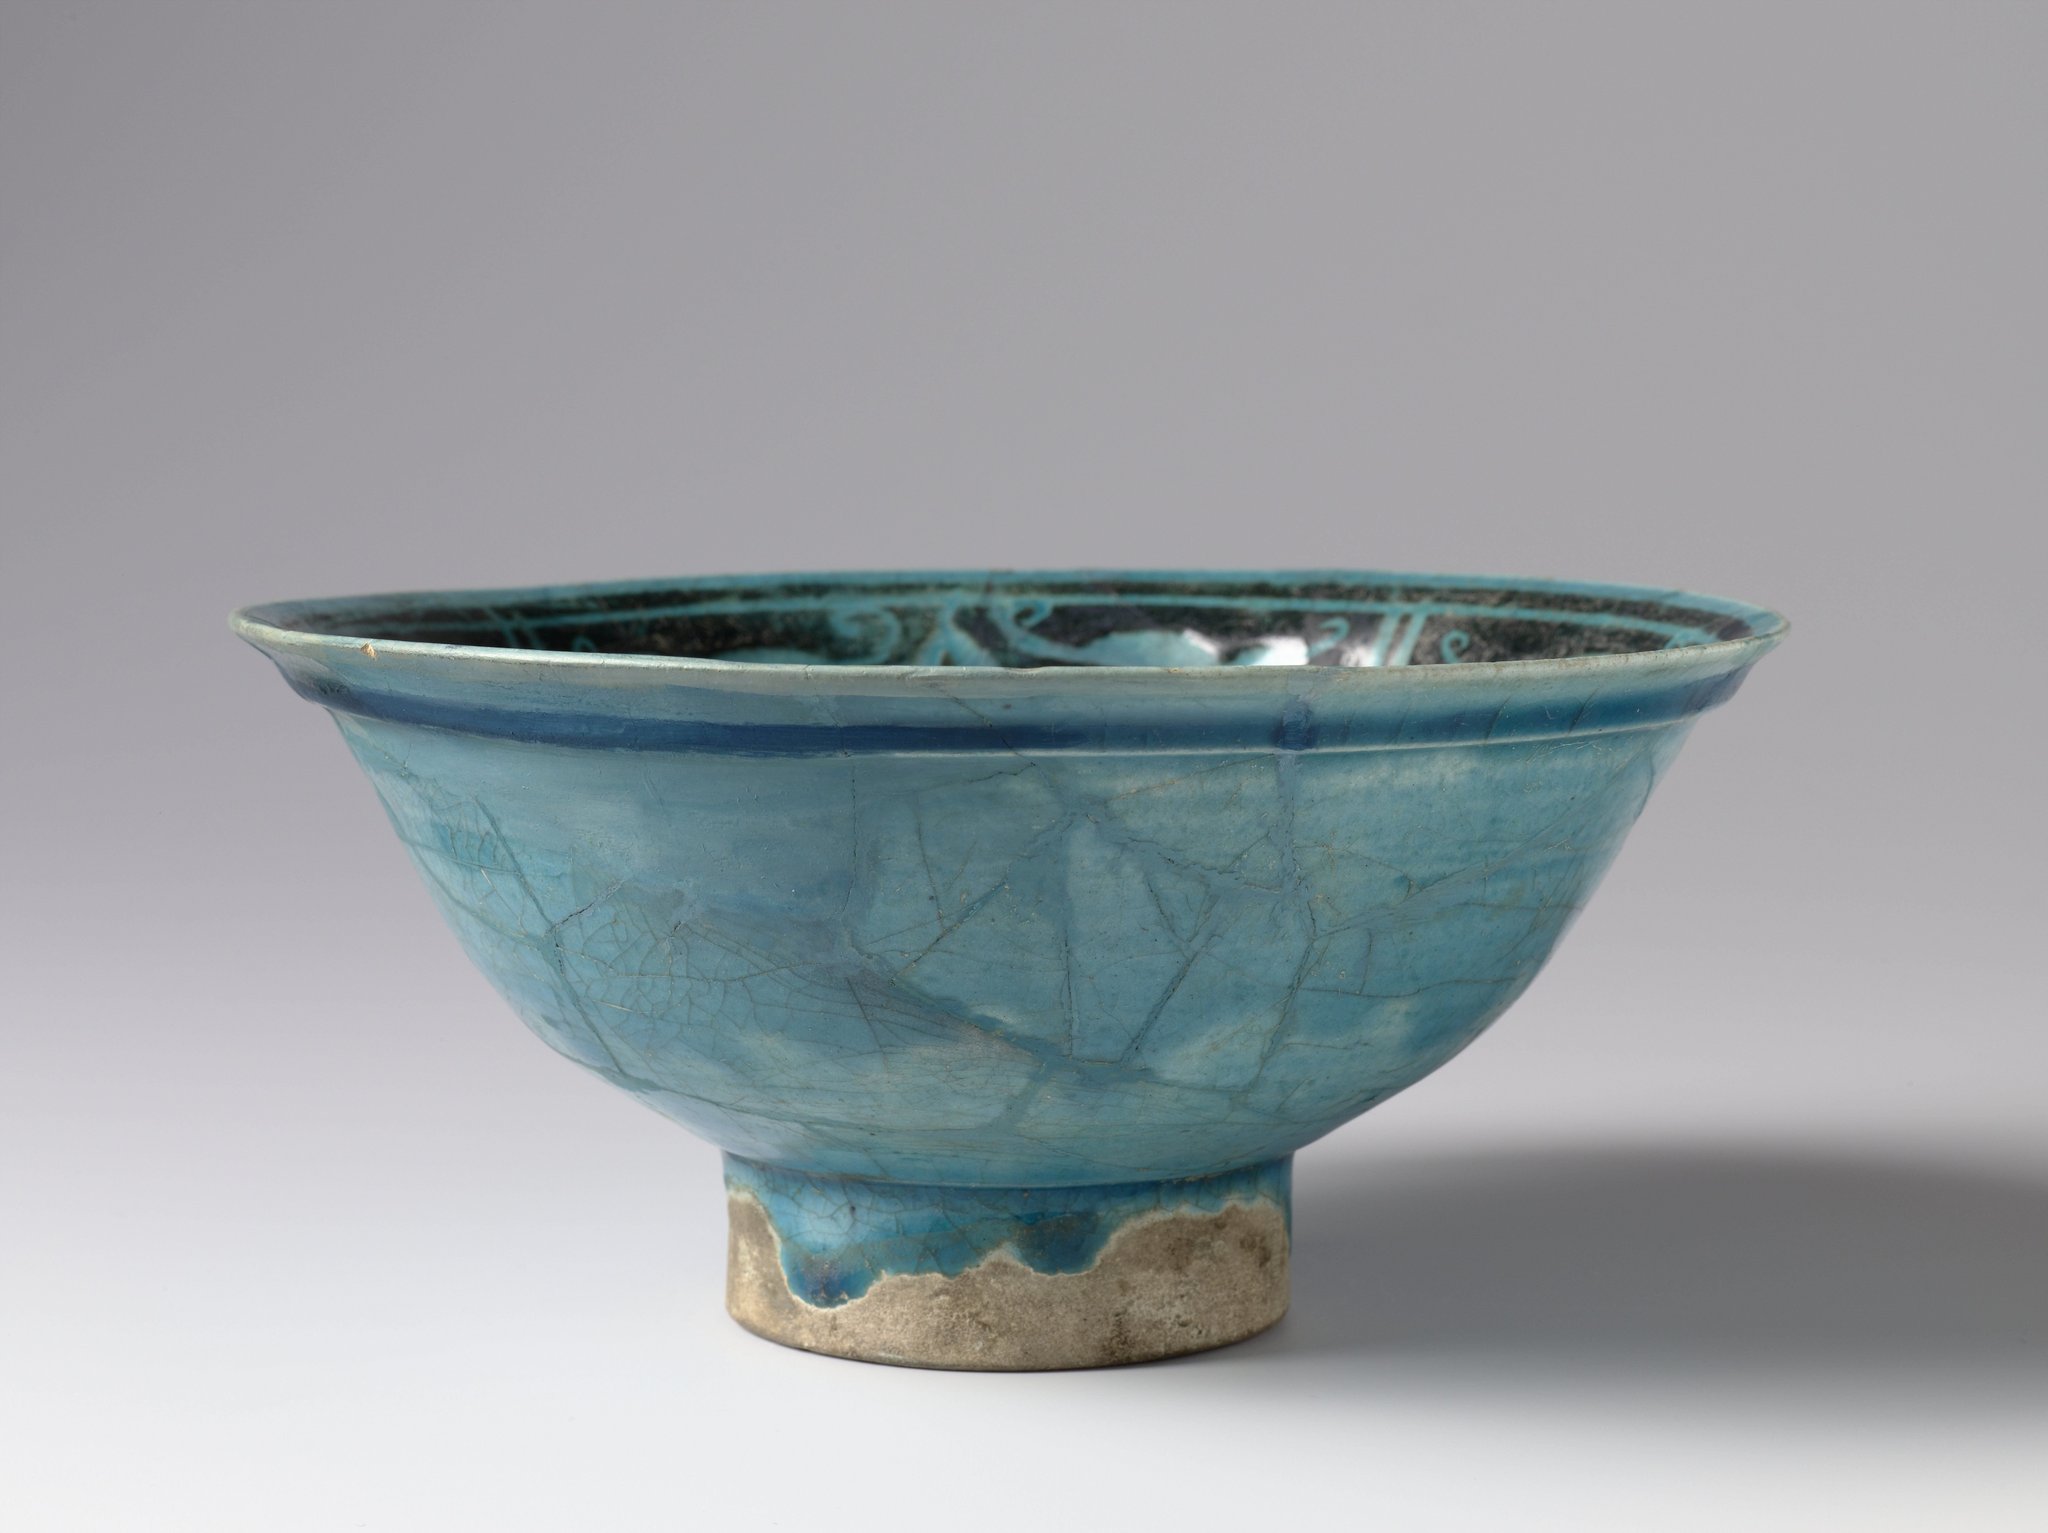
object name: bowl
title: Bowl with palmettes in four panels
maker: Anonymous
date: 1175-1199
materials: earthenware, glaze, quartz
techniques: cutting, firing, turning, vitrification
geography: iran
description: Kom van kwarts-fritgoed bedekt met engobe van zwarte slib waaruit halfpalmetten zijn weggesneden in "silhouette" onder een transparant monochrome turquoise glazuur.